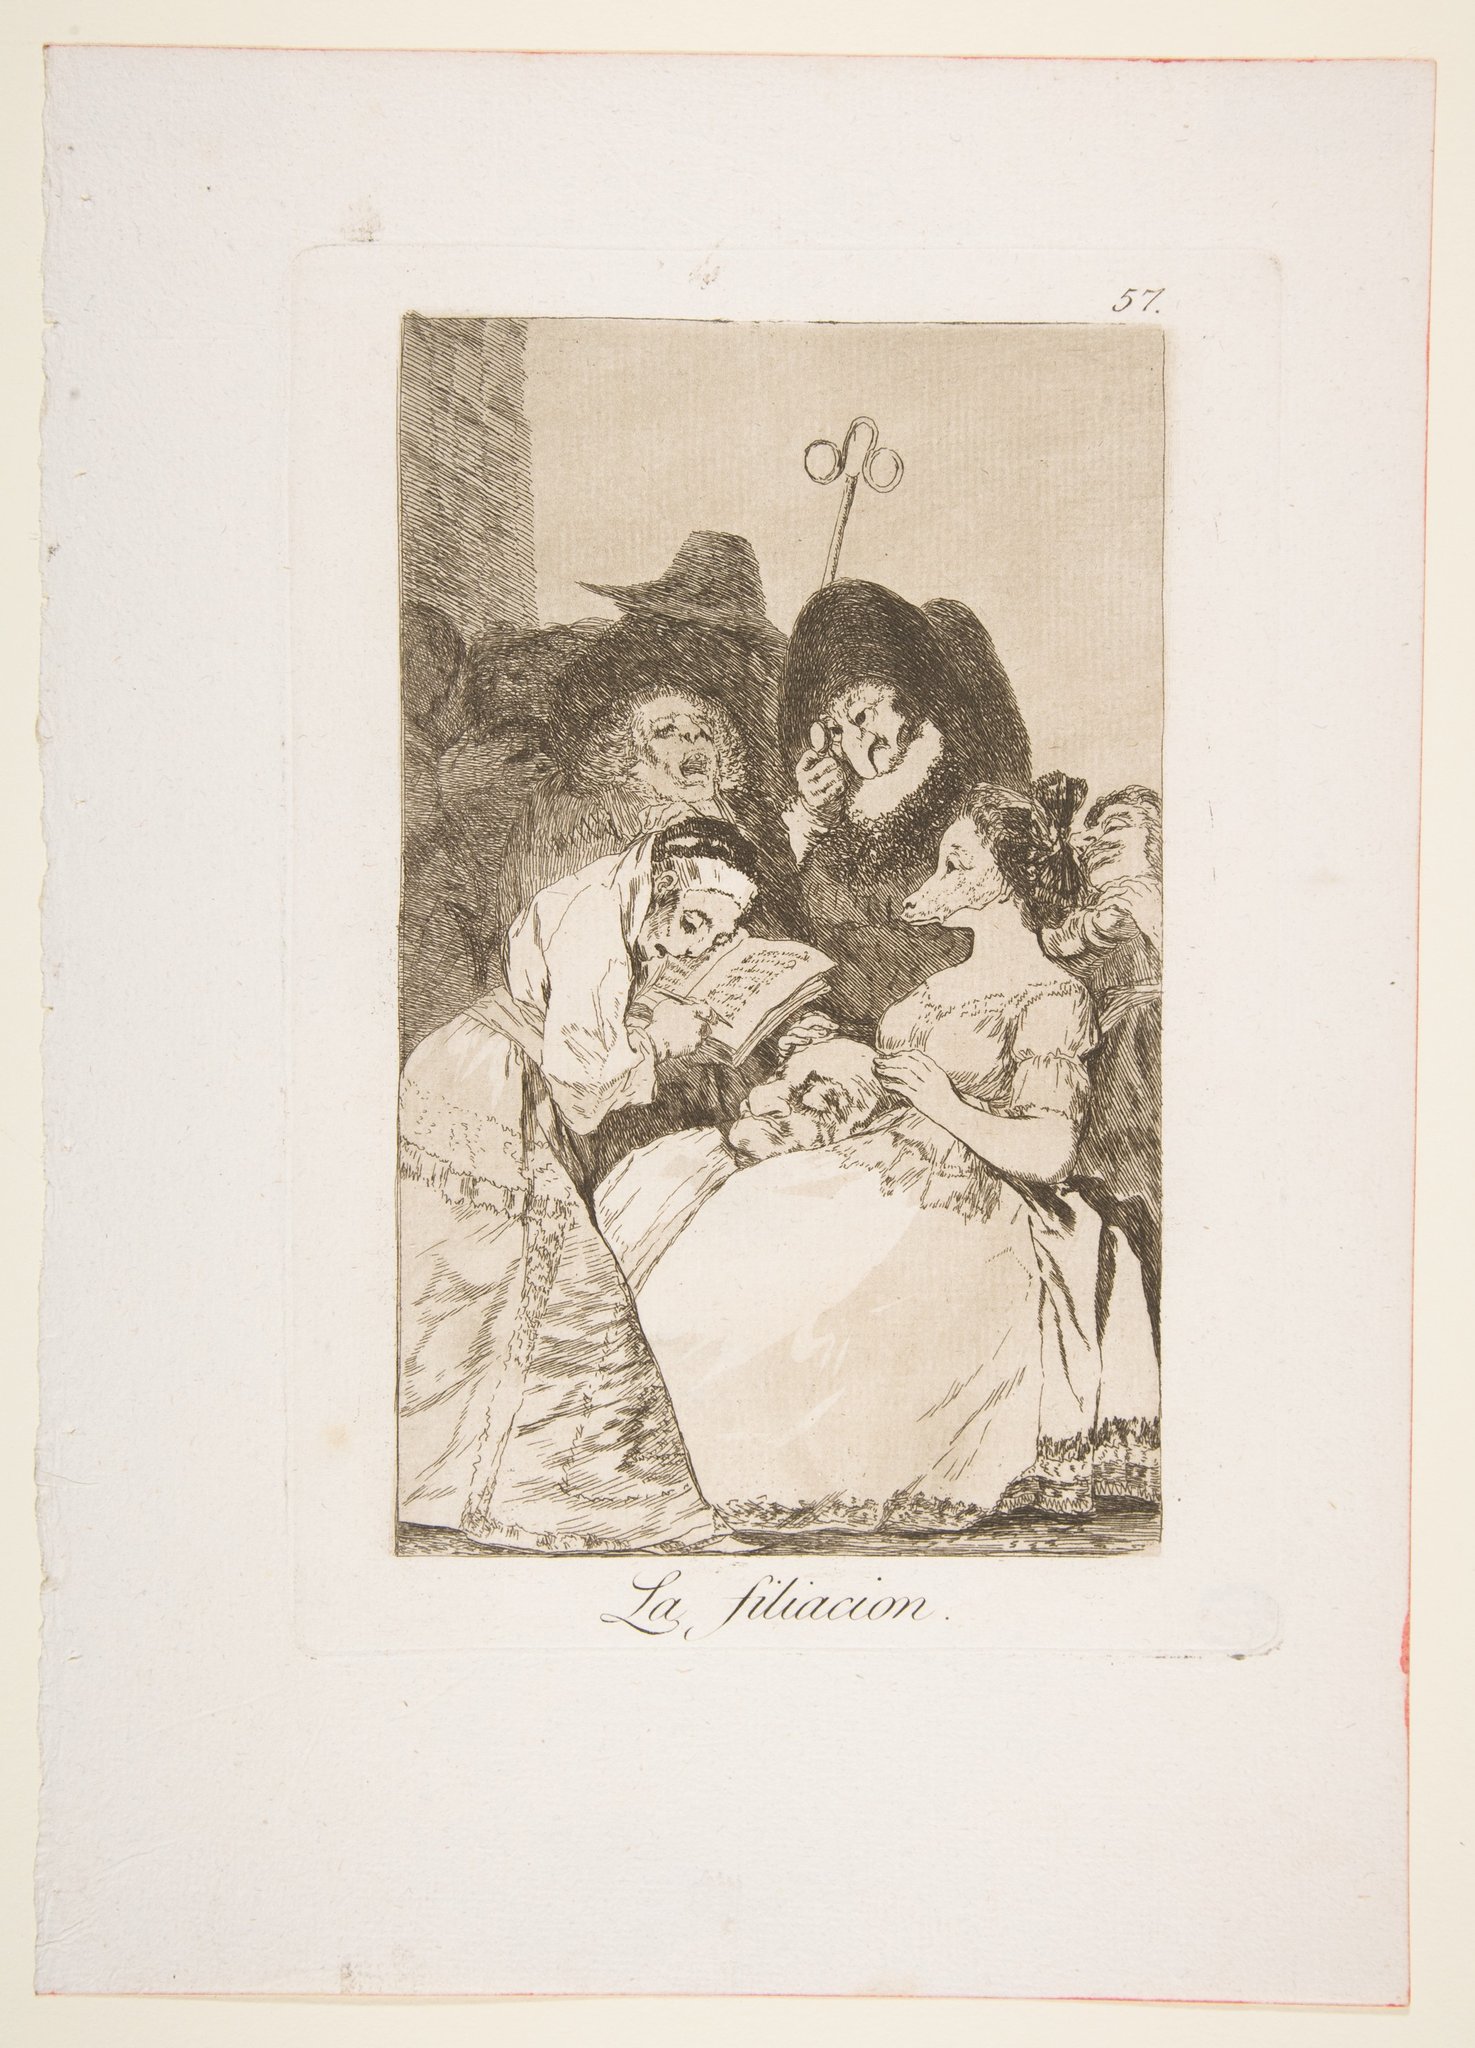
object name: print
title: Plate 57 from "Los Caprichos": The filiation (La filiacion)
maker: goya (francisco de goya y lucientes)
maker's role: artist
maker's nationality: spanish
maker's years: 1746-1828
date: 1799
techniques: aquatint, etching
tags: books,women